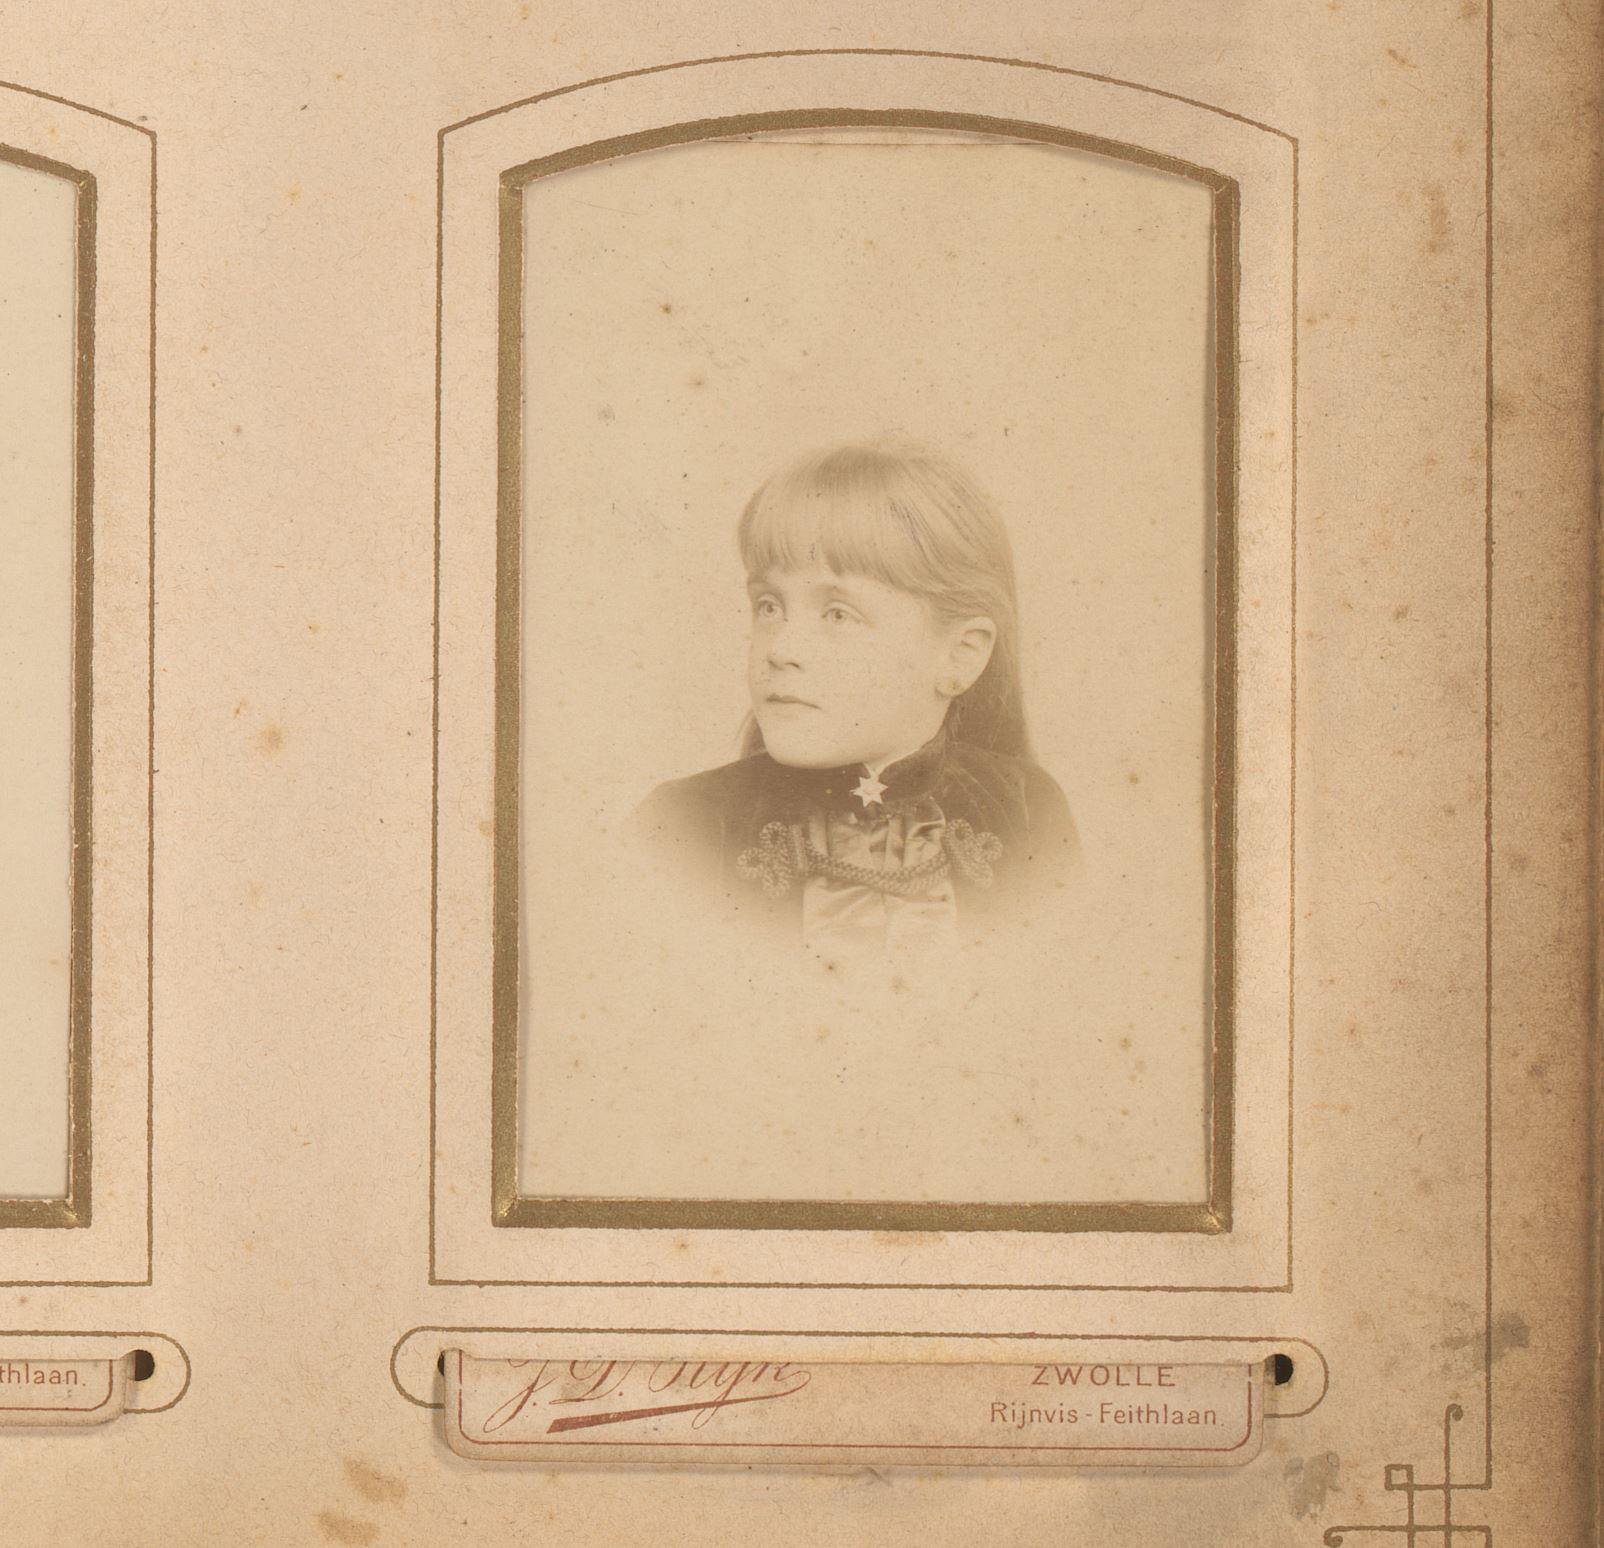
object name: album leaf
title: Portret van een meisje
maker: jacques daniël rijk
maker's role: draughtsman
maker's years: 1855-1912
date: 1888-1894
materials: cardboard, photographic support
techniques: albumen print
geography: zwolle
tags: historical persons - bb - woman, girl (child between toddler and youth)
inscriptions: inscription: ‘J.D. Rijk/ Zwolle/ Rhijnvis - Feithlaan’